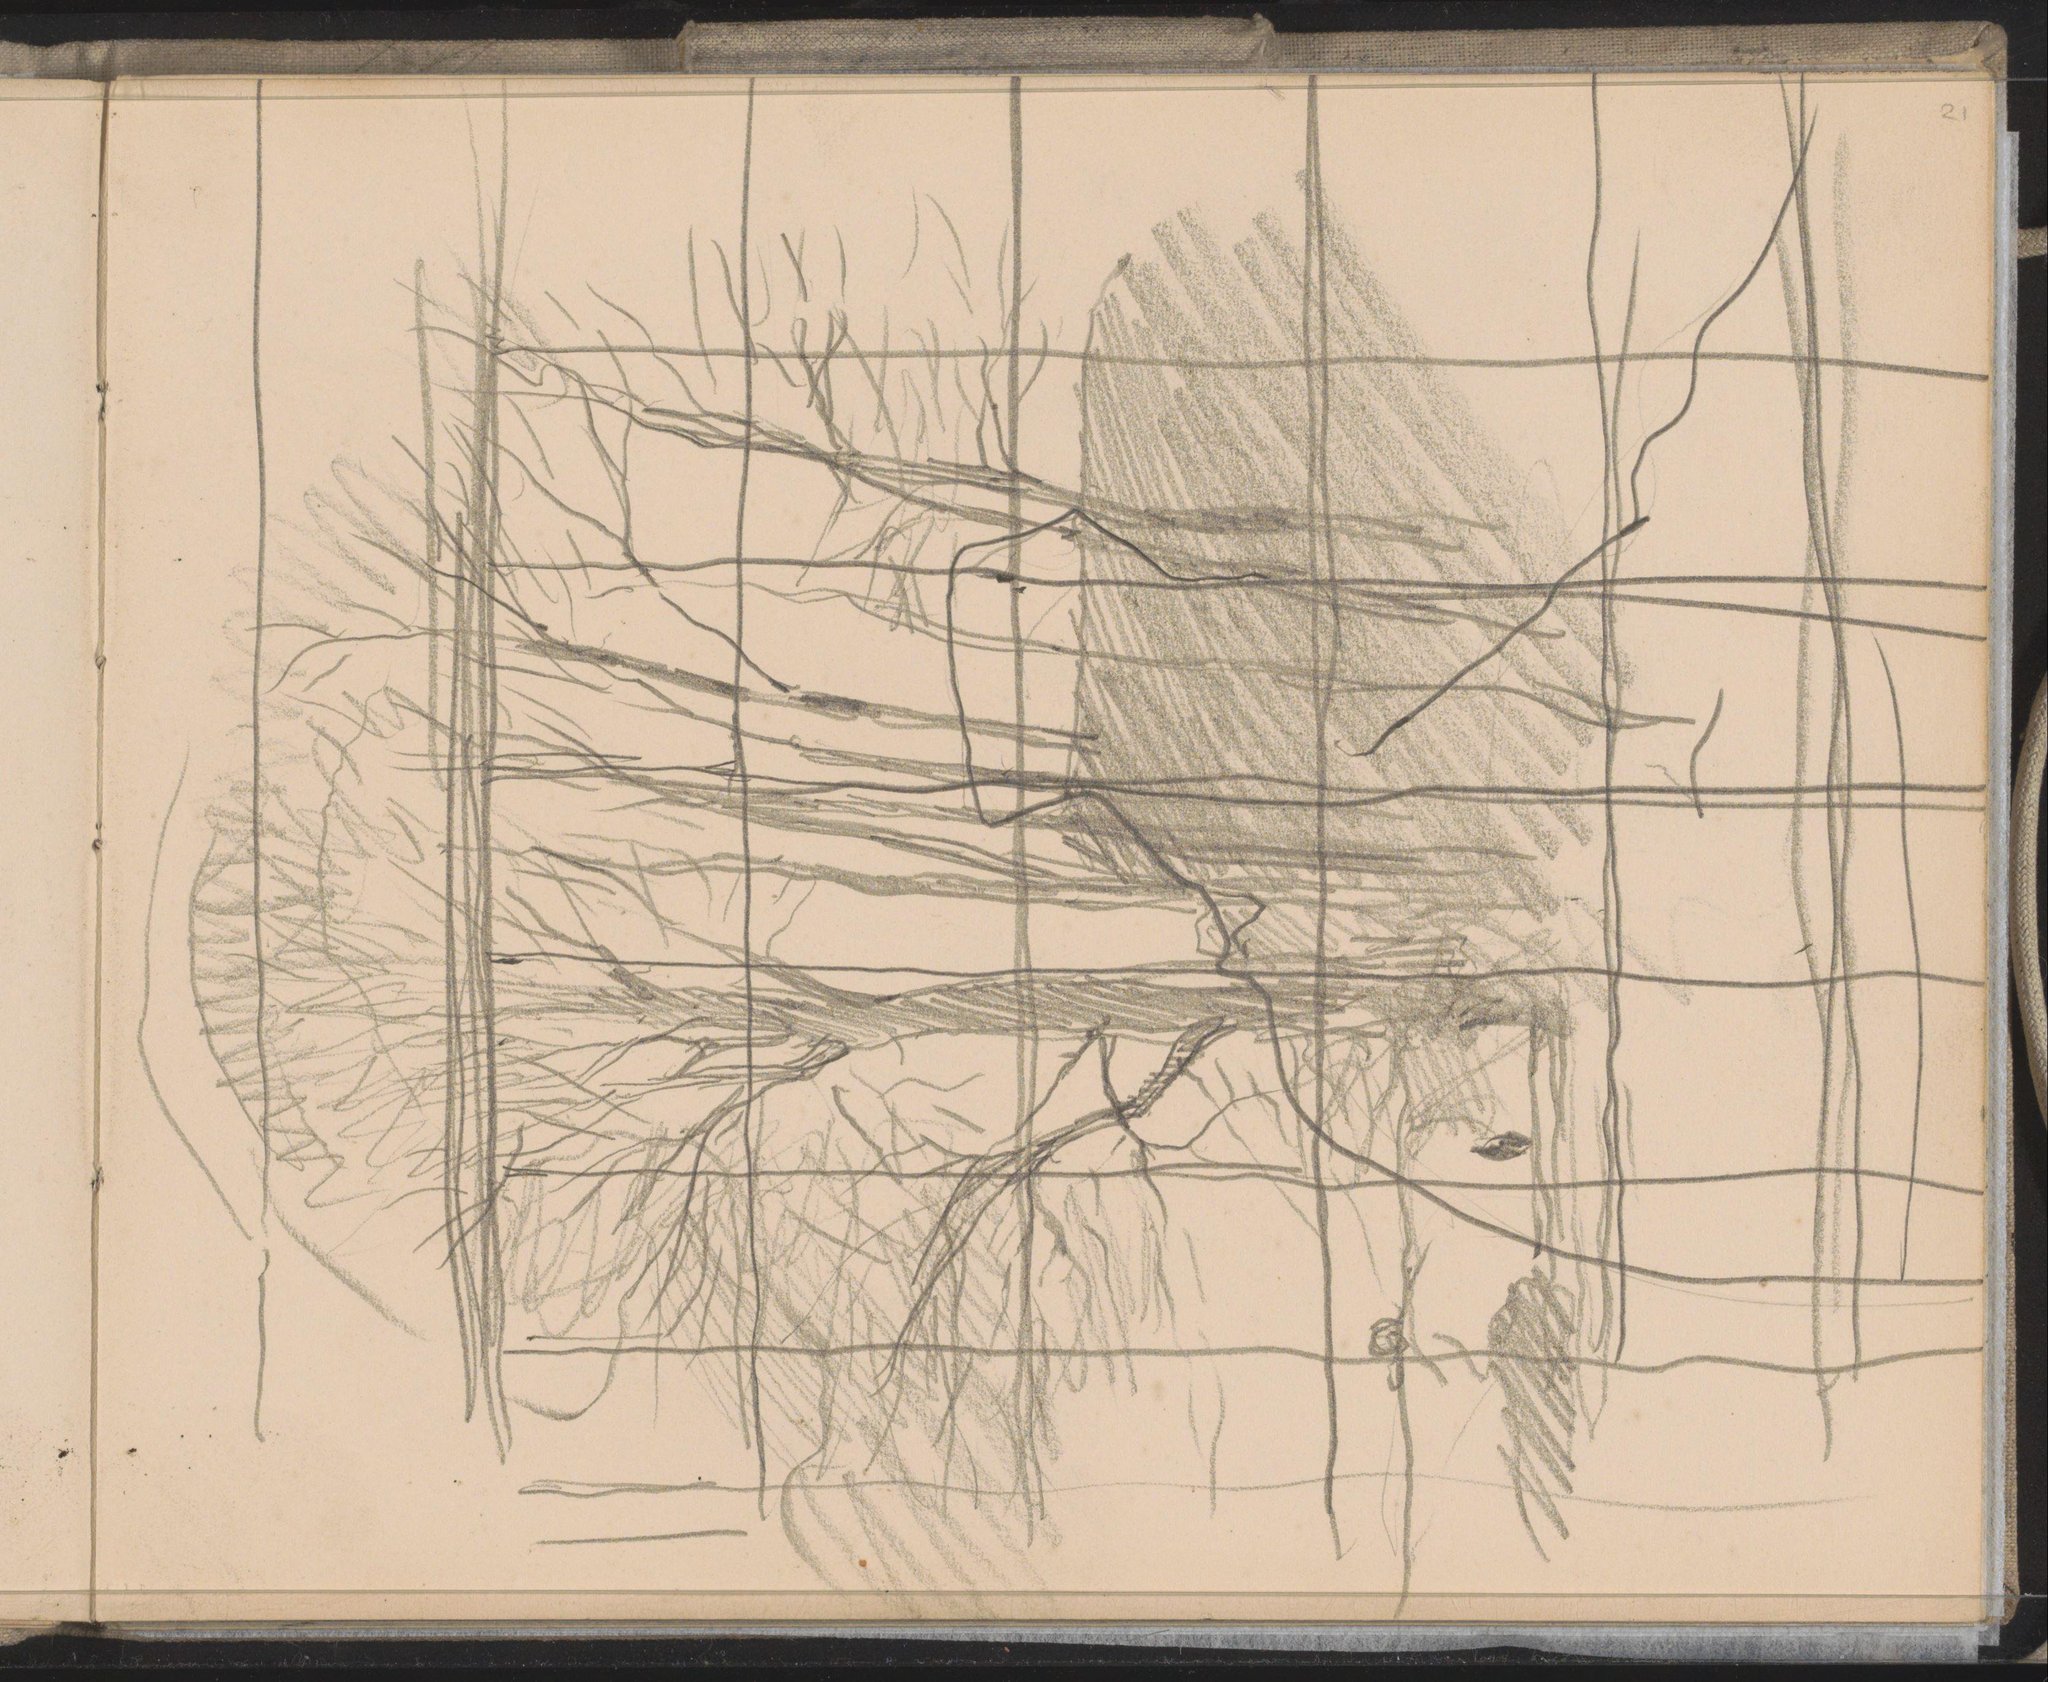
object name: sketchbook leaf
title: Man en een landschap met bebouwing, gezien door een raam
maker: willem witsen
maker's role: draughtsman, painter, print maker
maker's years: 1860-1923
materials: paper, pencil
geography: wijk bij duurstede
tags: landscapes, adult man, civic architecture; edifices; dwellings, wijk bij duurstede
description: Pagina 21 uit een schetsboek met 43 bladen.